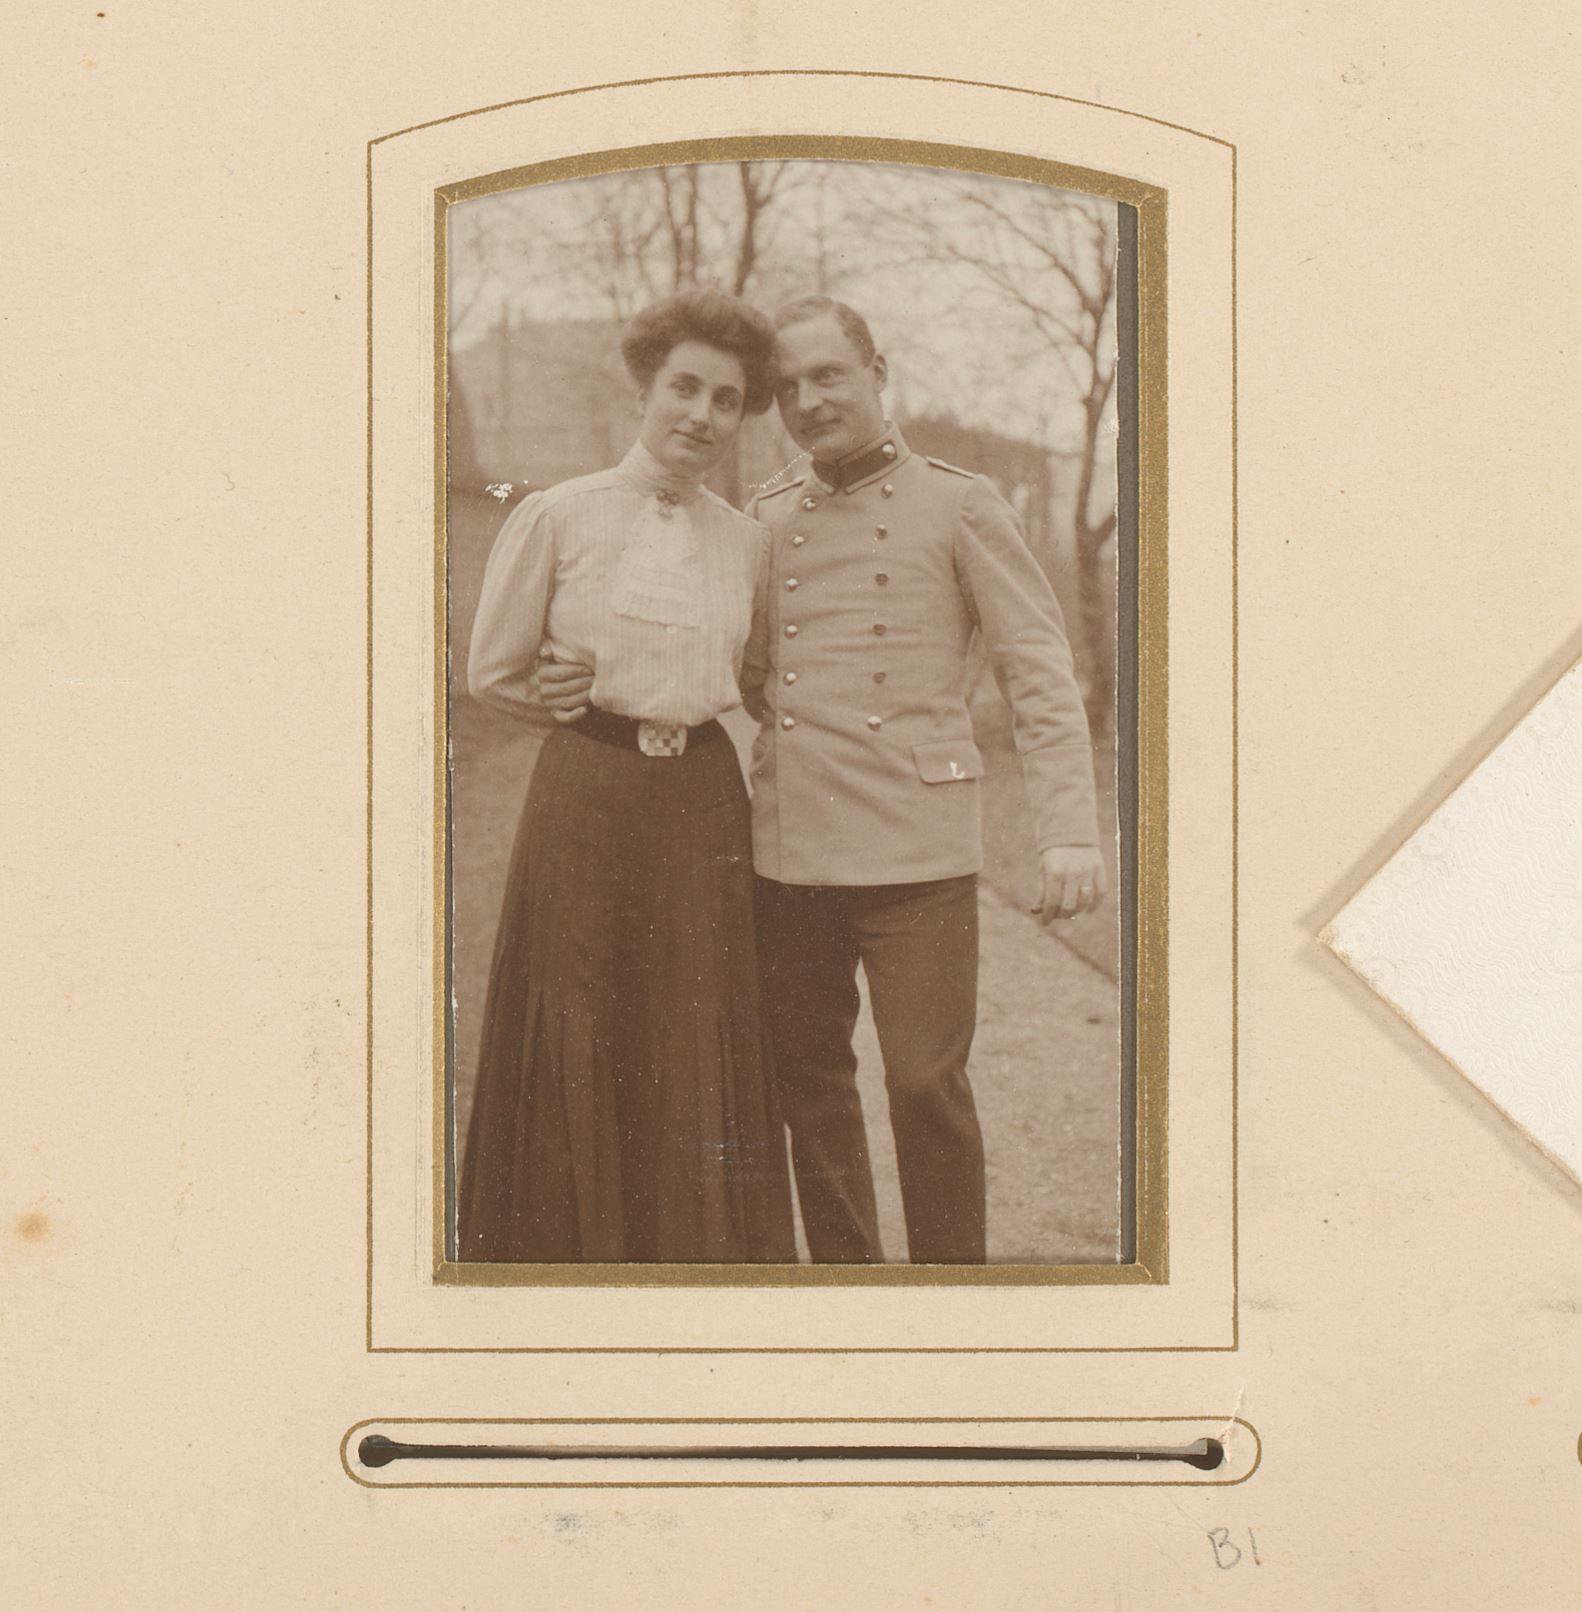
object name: album leaf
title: Portret van een vrouw en een man in militair uniform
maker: Anonymous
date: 1901-1910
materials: cardboard, photographic support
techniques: collodion silver print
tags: historical persons - bb - woman, historical persons, (military) uniforms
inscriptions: annotation: ‘Grete Brecht u./ Oscar S[...]/ Januar 1910/ in [...] Garten.’